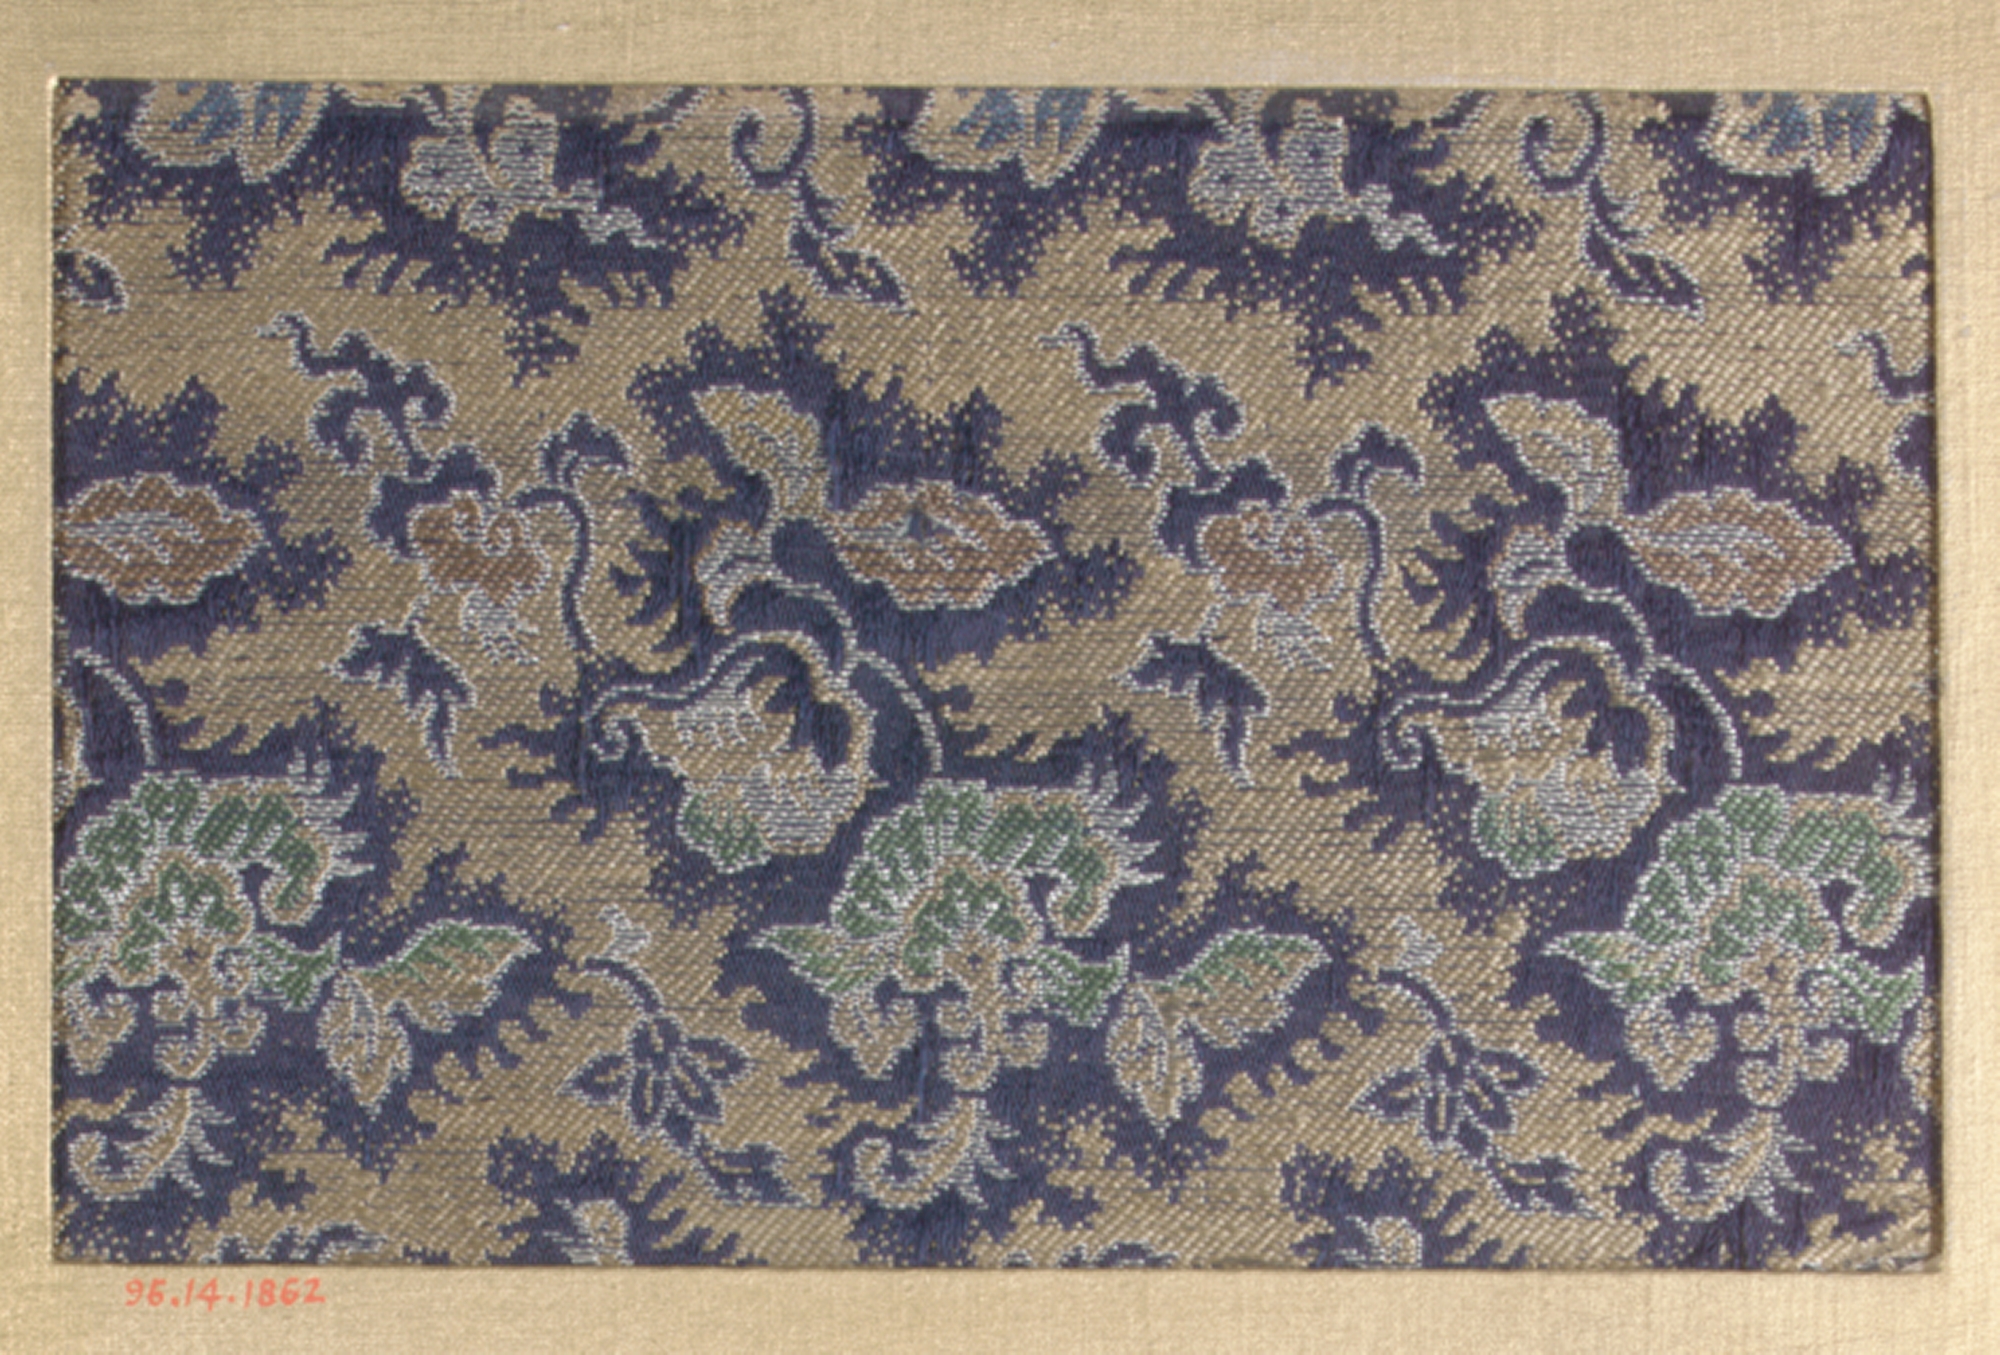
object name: piece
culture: japanese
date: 1701-1900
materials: silk